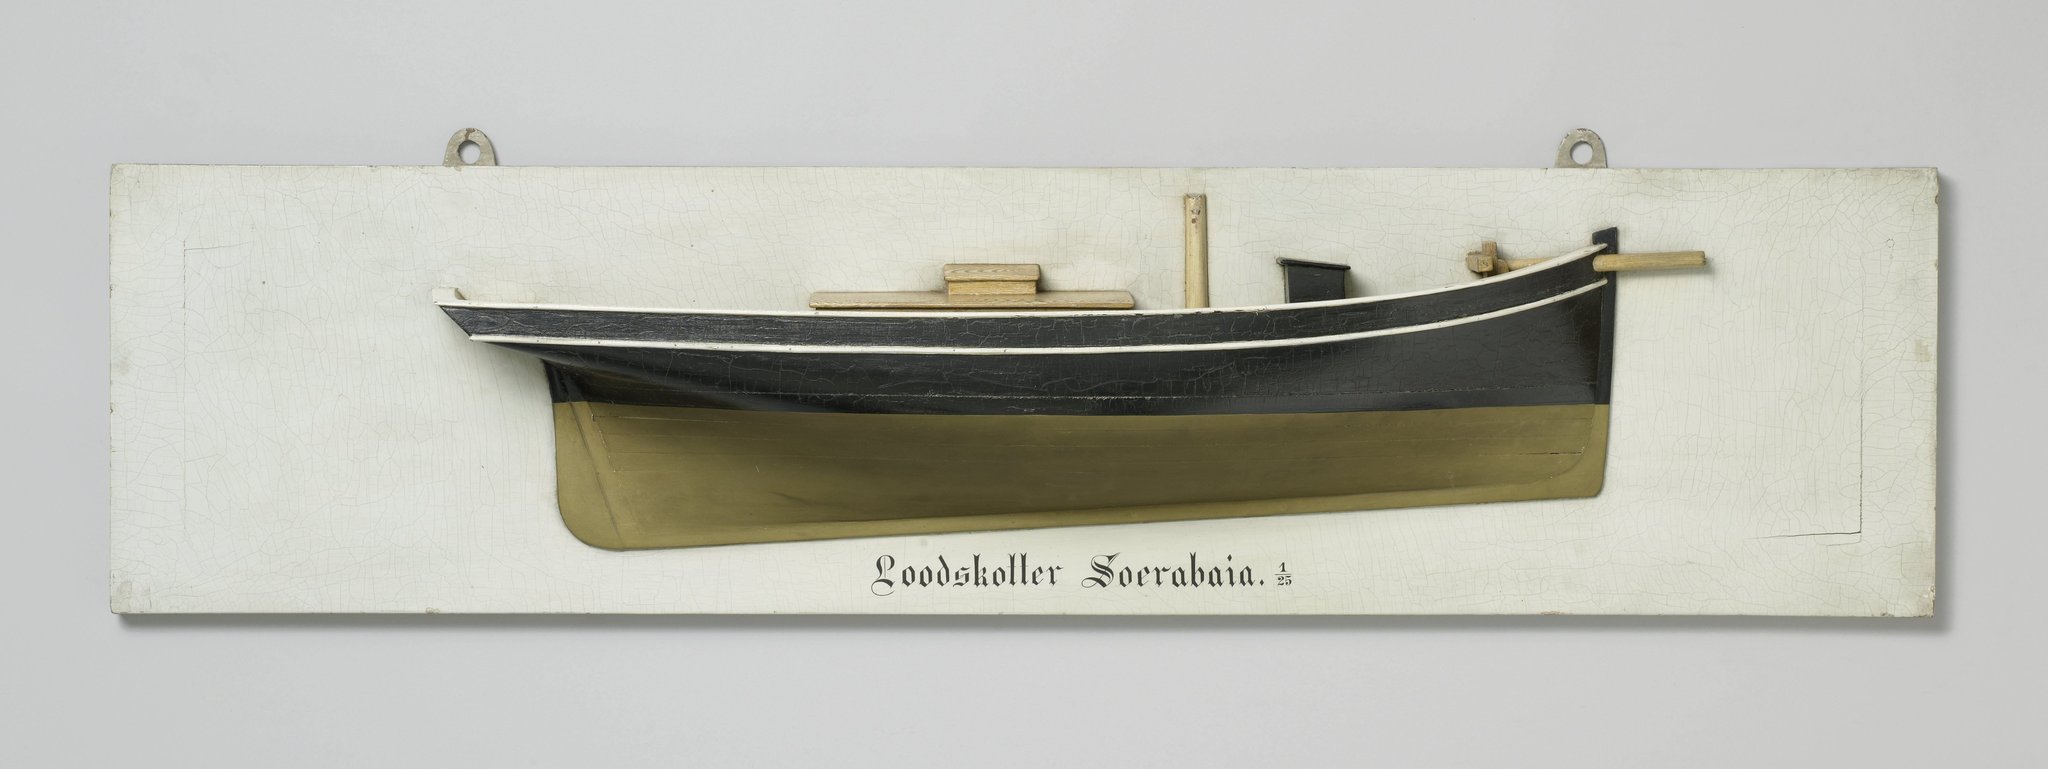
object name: builder's model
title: Half model of a pilot cutter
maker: Anonymous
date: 1860-1880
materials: wood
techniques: polychromy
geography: indonesian archipelago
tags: soerabaia (schip)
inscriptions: inscription, bottom centre, in a Gothic hand: ‘Loodskotter Soerabaia. 1/25.’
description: Gepolychromeerd blokmodel(?) (stuurboord) van een eenmast kotter. Verticale voorsteven. Overhangend hek met klein, plat hekkebord; roer met ronde roerkoning (Amerikaans roer) en afgerond roerblad. Aan dek een dekopbouw en een opgang. De zeeg loopt naar beide uiteinden iets op, een reehout. V-vormig onderwaterschip met veel stuurlast. De boegspriet ligt naast de voorsteven. Schaal 1:25 (schaal op model).